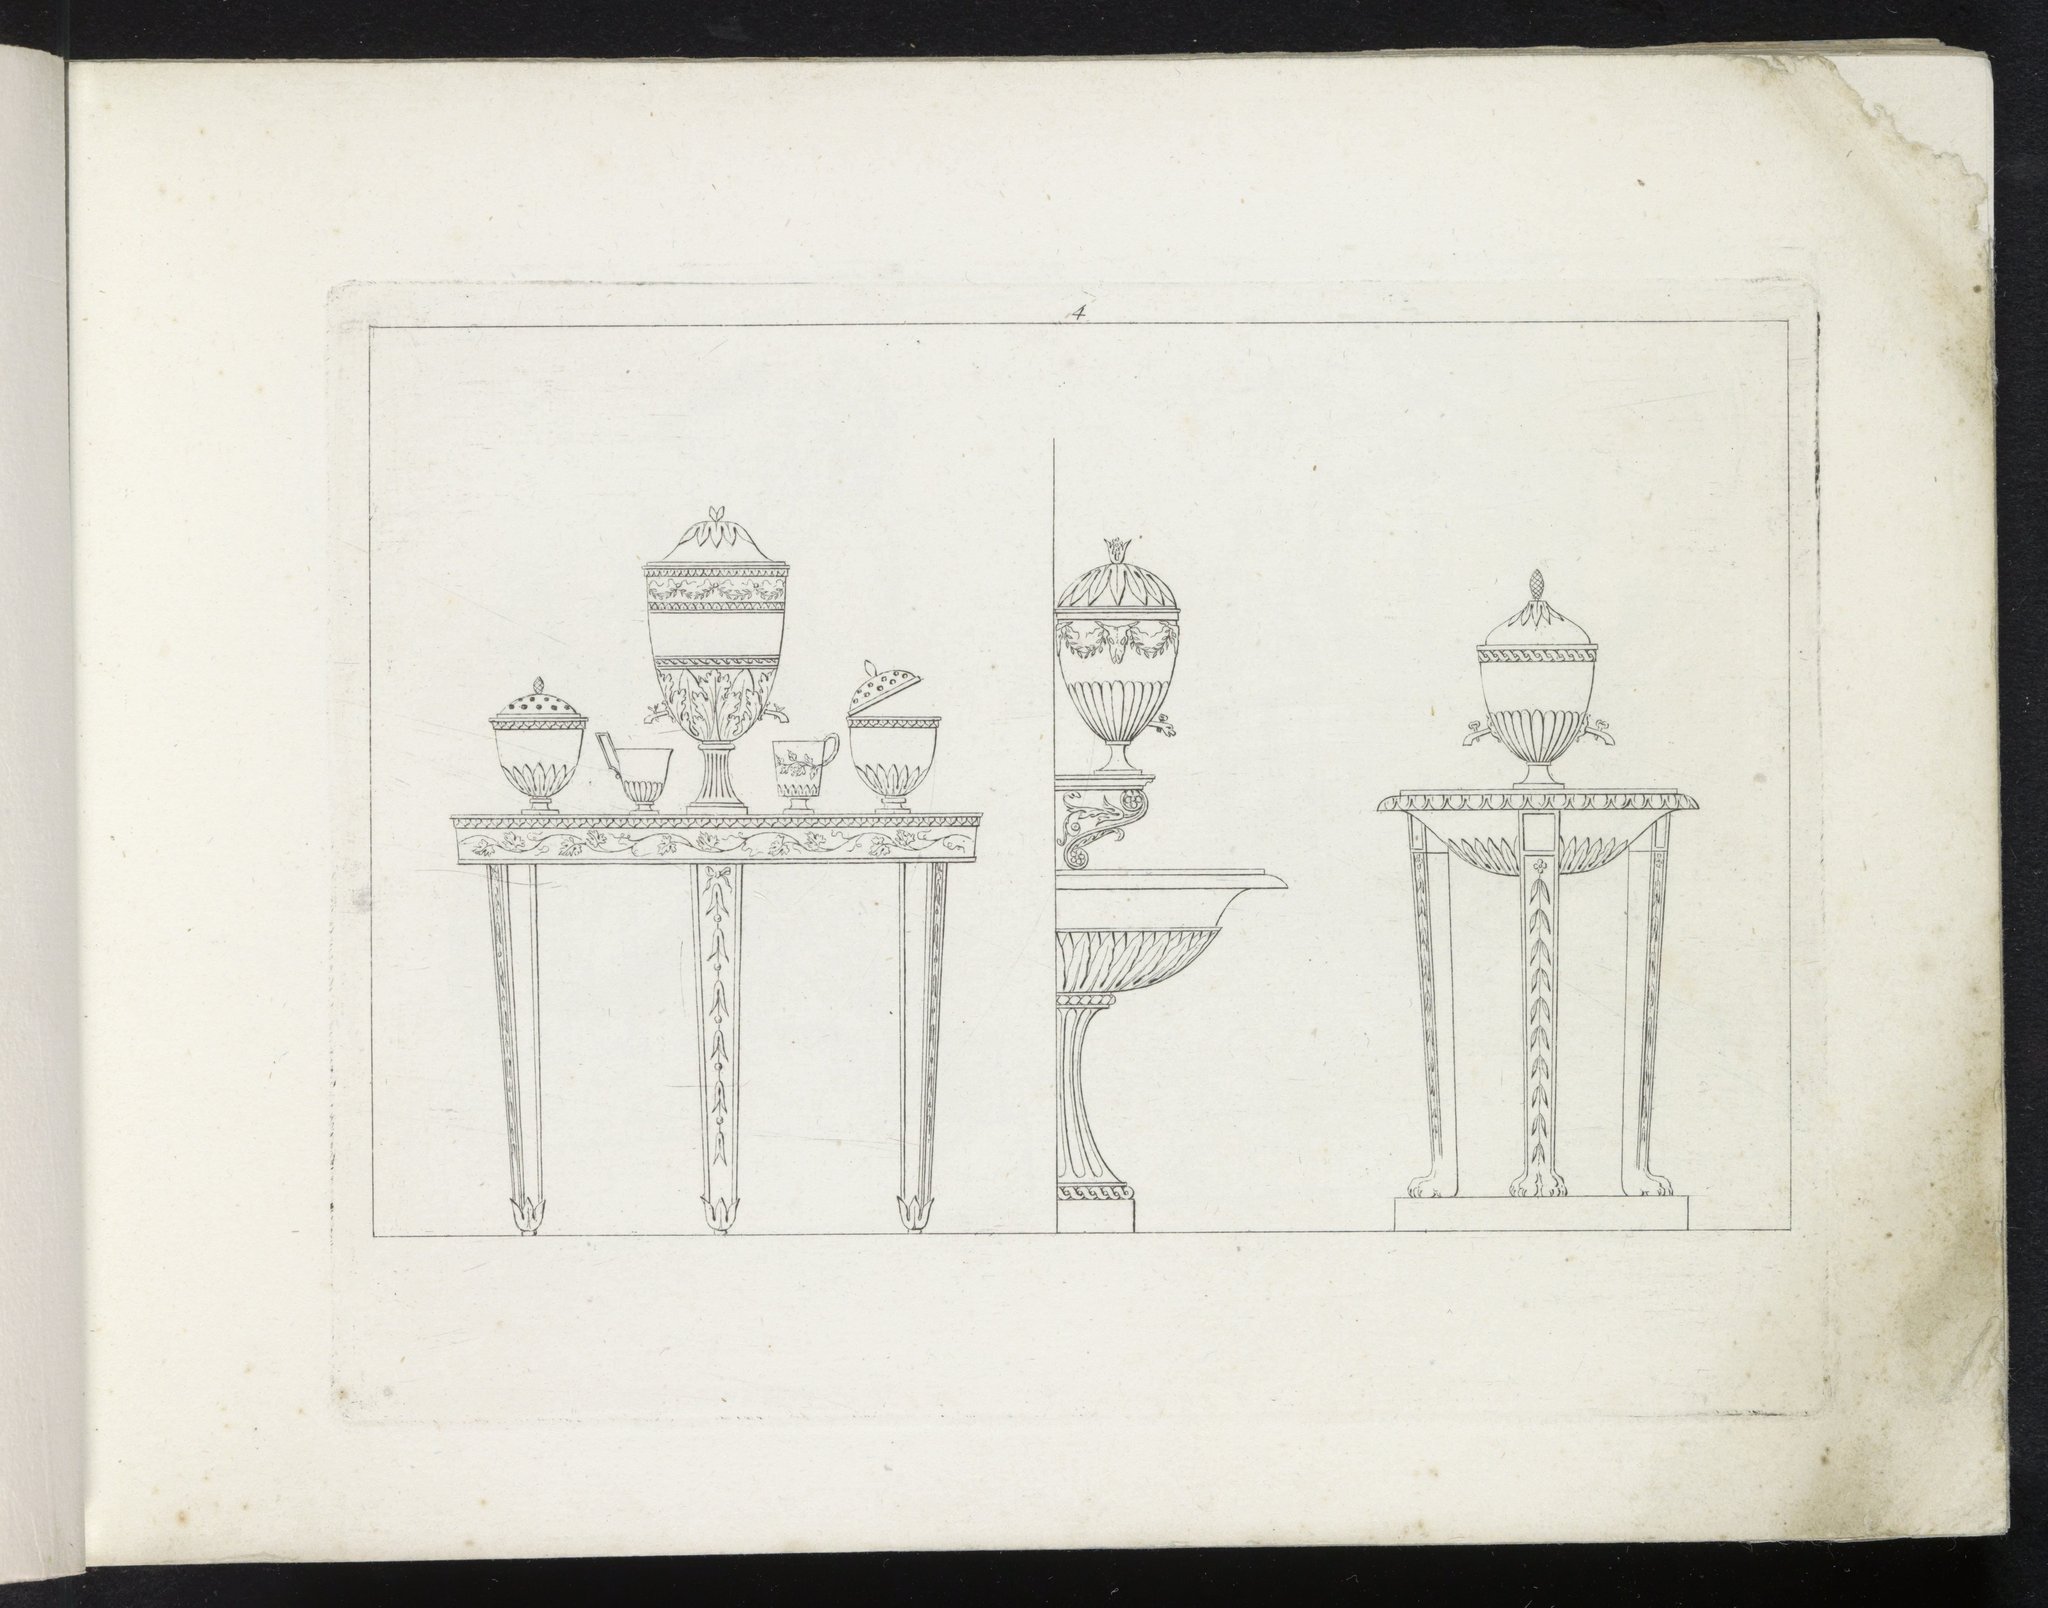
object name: ornament print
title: Lijst met voorstelling van Amor en Psyche, een bank en twee schalen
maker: pietro ruga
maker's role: print maker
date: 1817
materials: paper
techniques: etching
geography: italy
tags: bench, ornaments ~ art, bowl, cupid and psyche as lovers, frame of painting, etc.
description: Prent maakt deel uit van een reeks van 100 prenten (+ titelprent) met ontwerpen voor religieuze en profane voorwerpen.